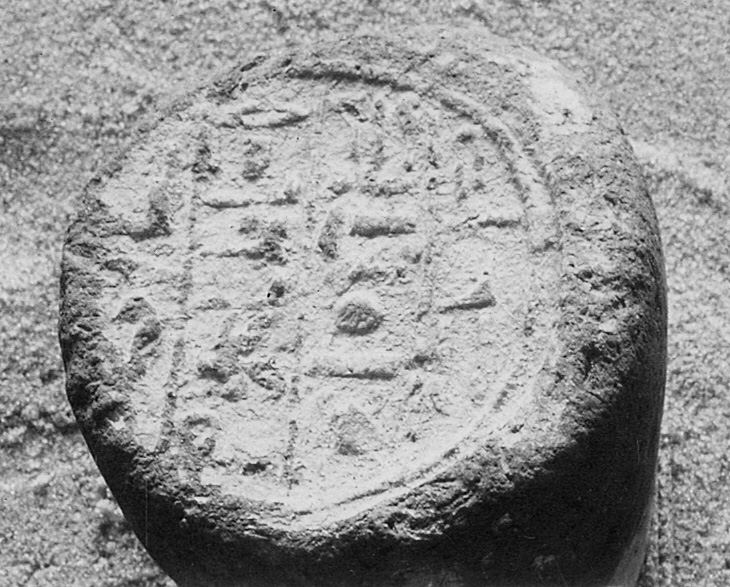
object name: cone, circular impression, menkheperresonb, high priest, amun, seal bearer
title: Funerary Cone of the High Priest of Amun Menkheperresonb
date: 1479-1425 BCE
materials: pottery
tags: hieroglyphs